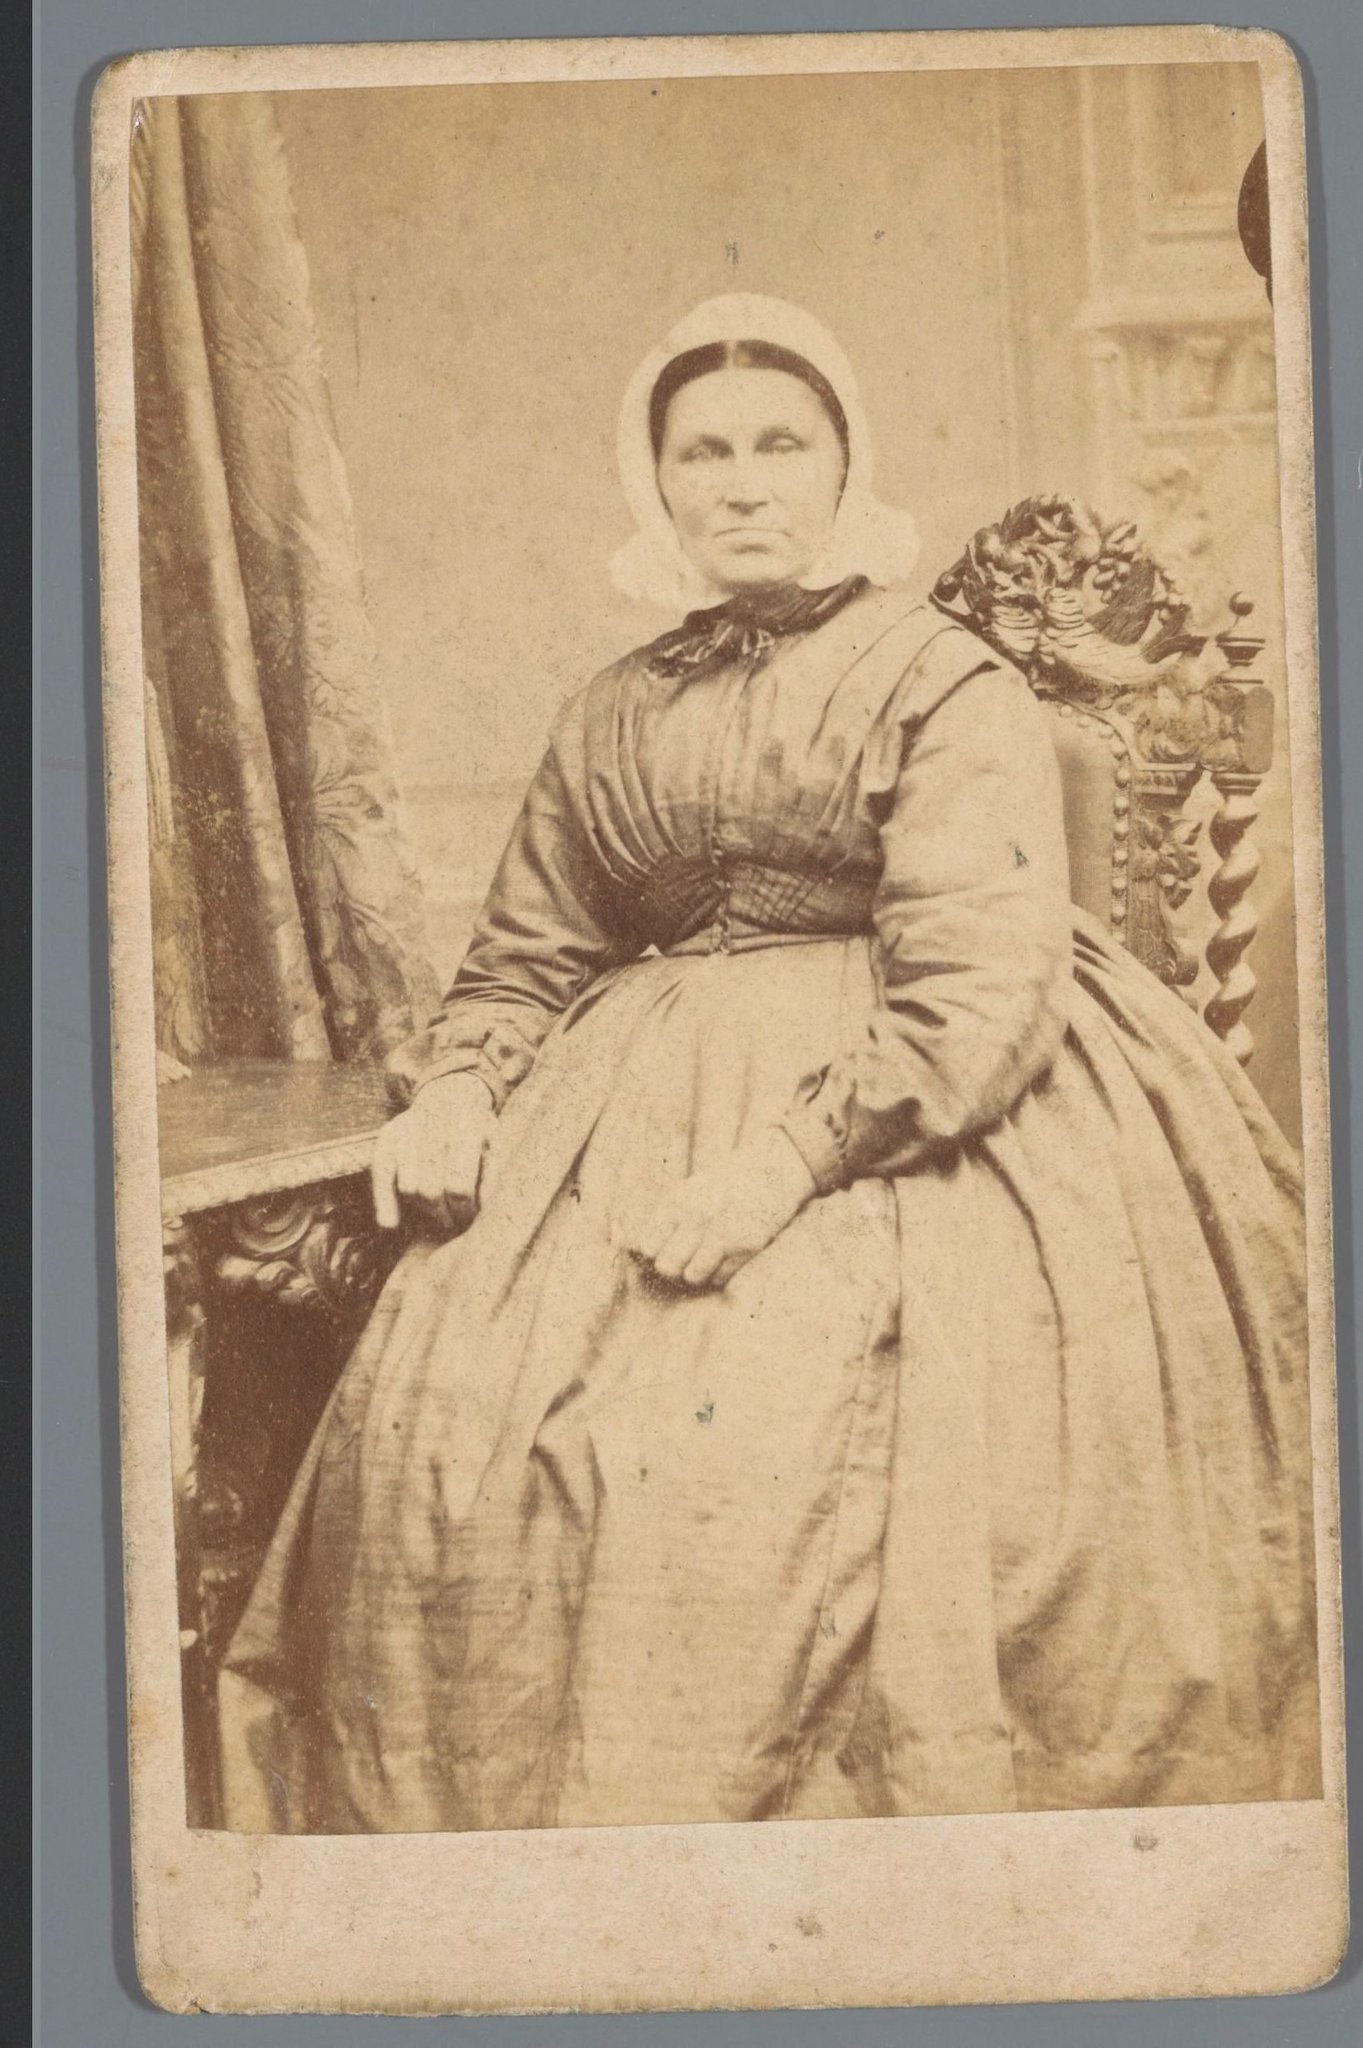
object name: carte de visite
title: Portret van een vrouw, aangeduid als Schouten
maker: johannes frederik hulk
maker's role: draughtsman, painter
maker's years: 1829-1911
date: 1864-1865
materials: cardboard, paper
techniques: albumen print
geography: amsterdam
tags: adult woman, anonymous historical person portrayed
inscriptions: address: ‘AMSTERDAM/ ROKIN E 167.’, inscription: ‘Schouten/ Kerkstraat/ tot 27 juni/ 78’, inscription: ‘ATELIER REMBRANDT./ H.’